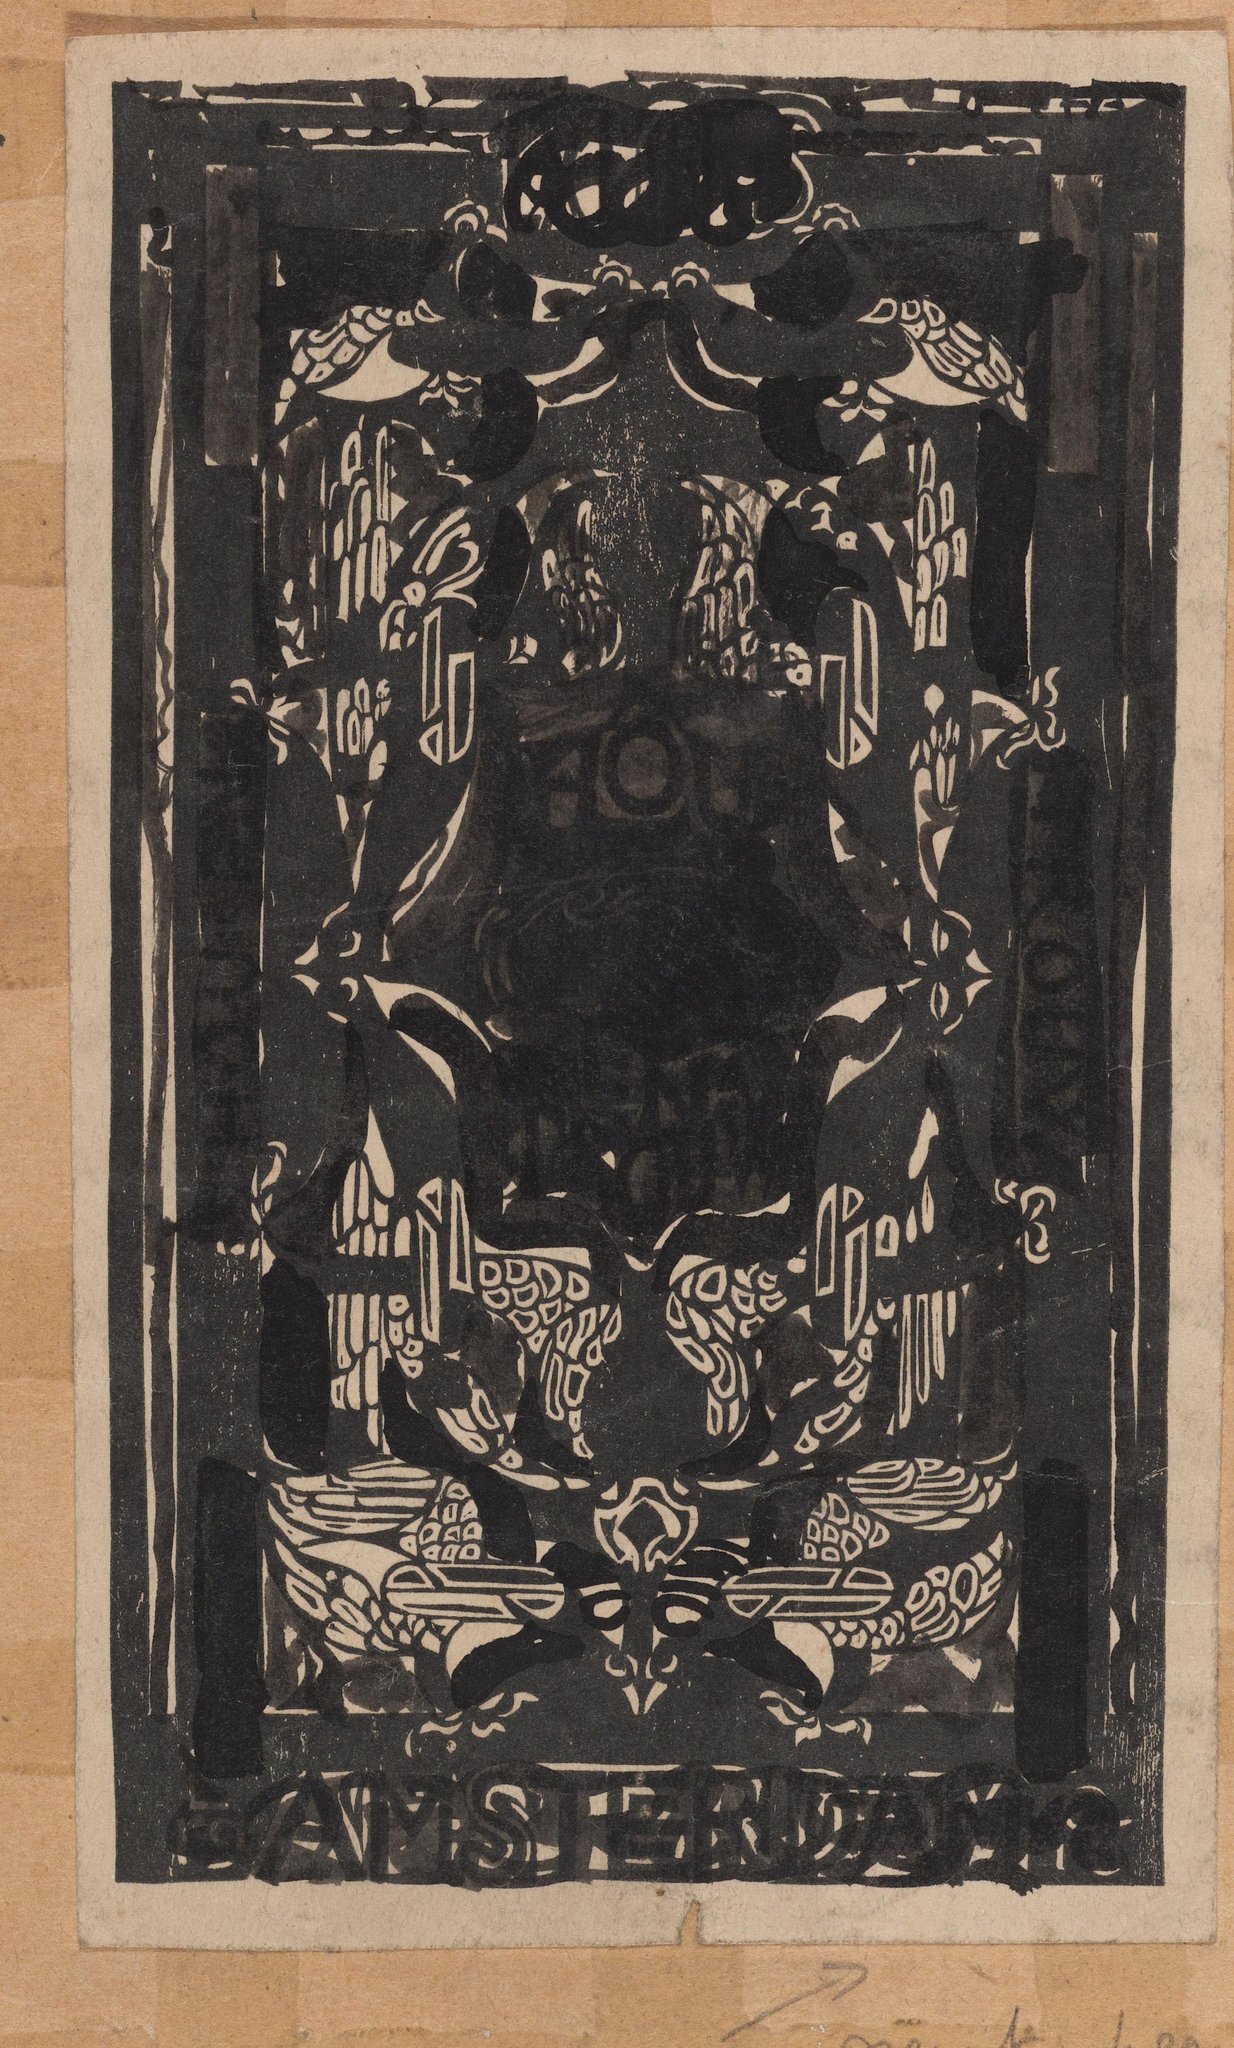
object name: drawing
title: Decoratief ontwerp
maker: carel adolph lion cachet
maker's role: draughtsman, print maker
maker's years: 1864-1945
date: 1874-1945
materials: pencil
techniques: brush